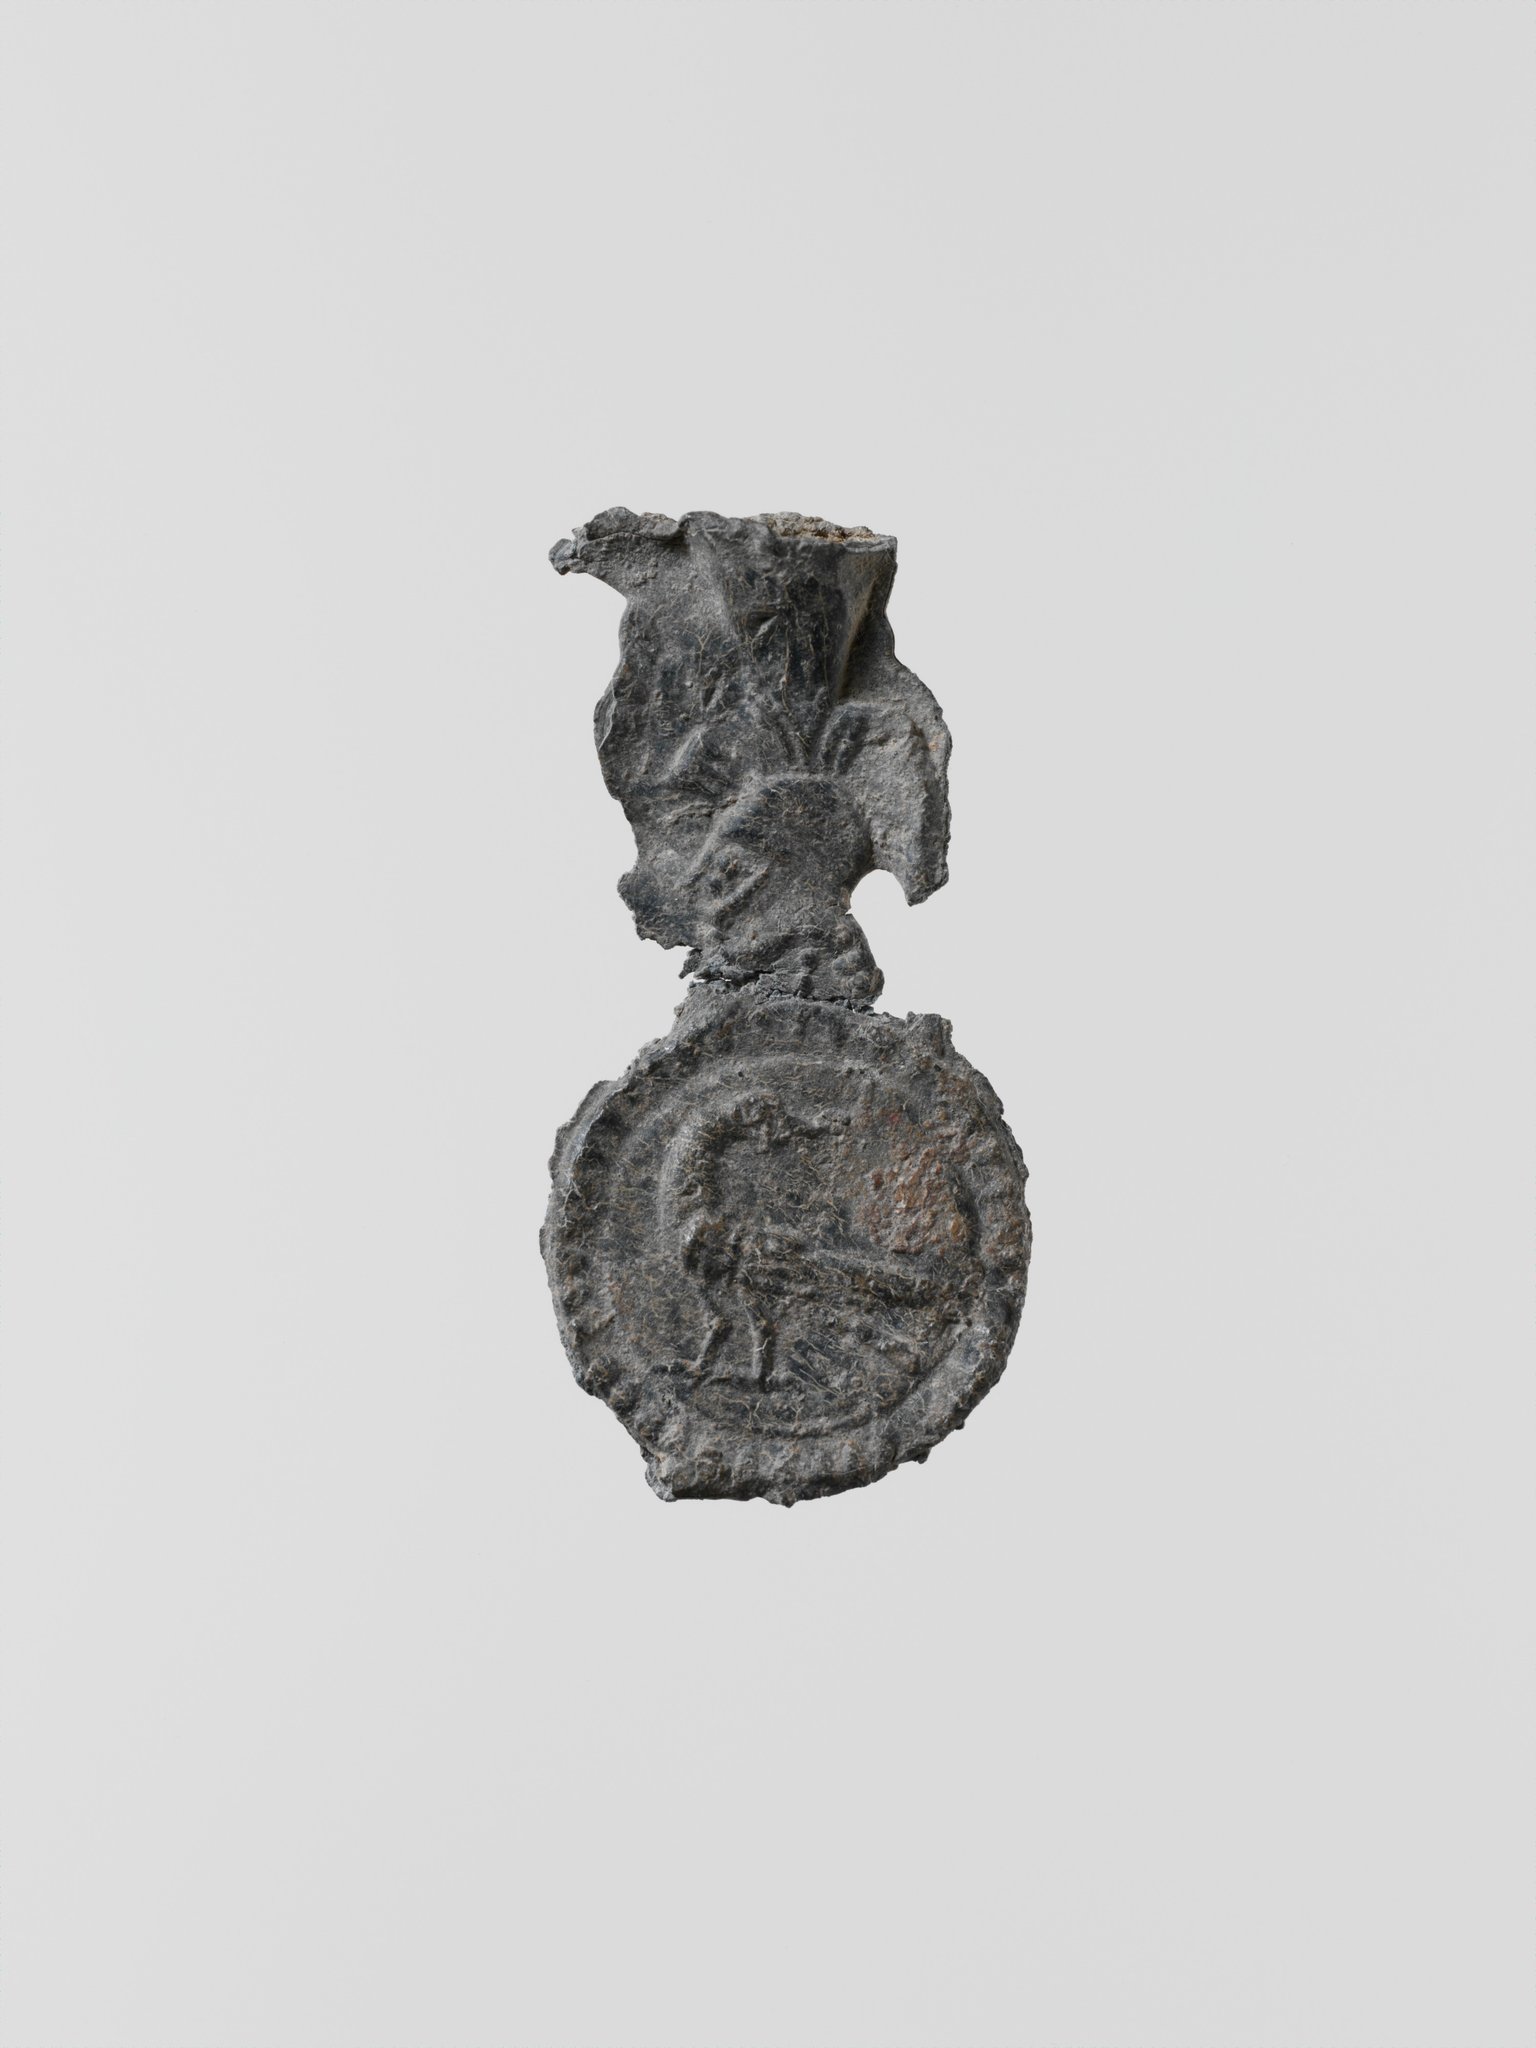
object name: statuette of a warrior 7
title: Statuette of a warrior-7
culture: greek, laconian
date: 7000-30 BCE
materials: lead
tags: birds,soldiers